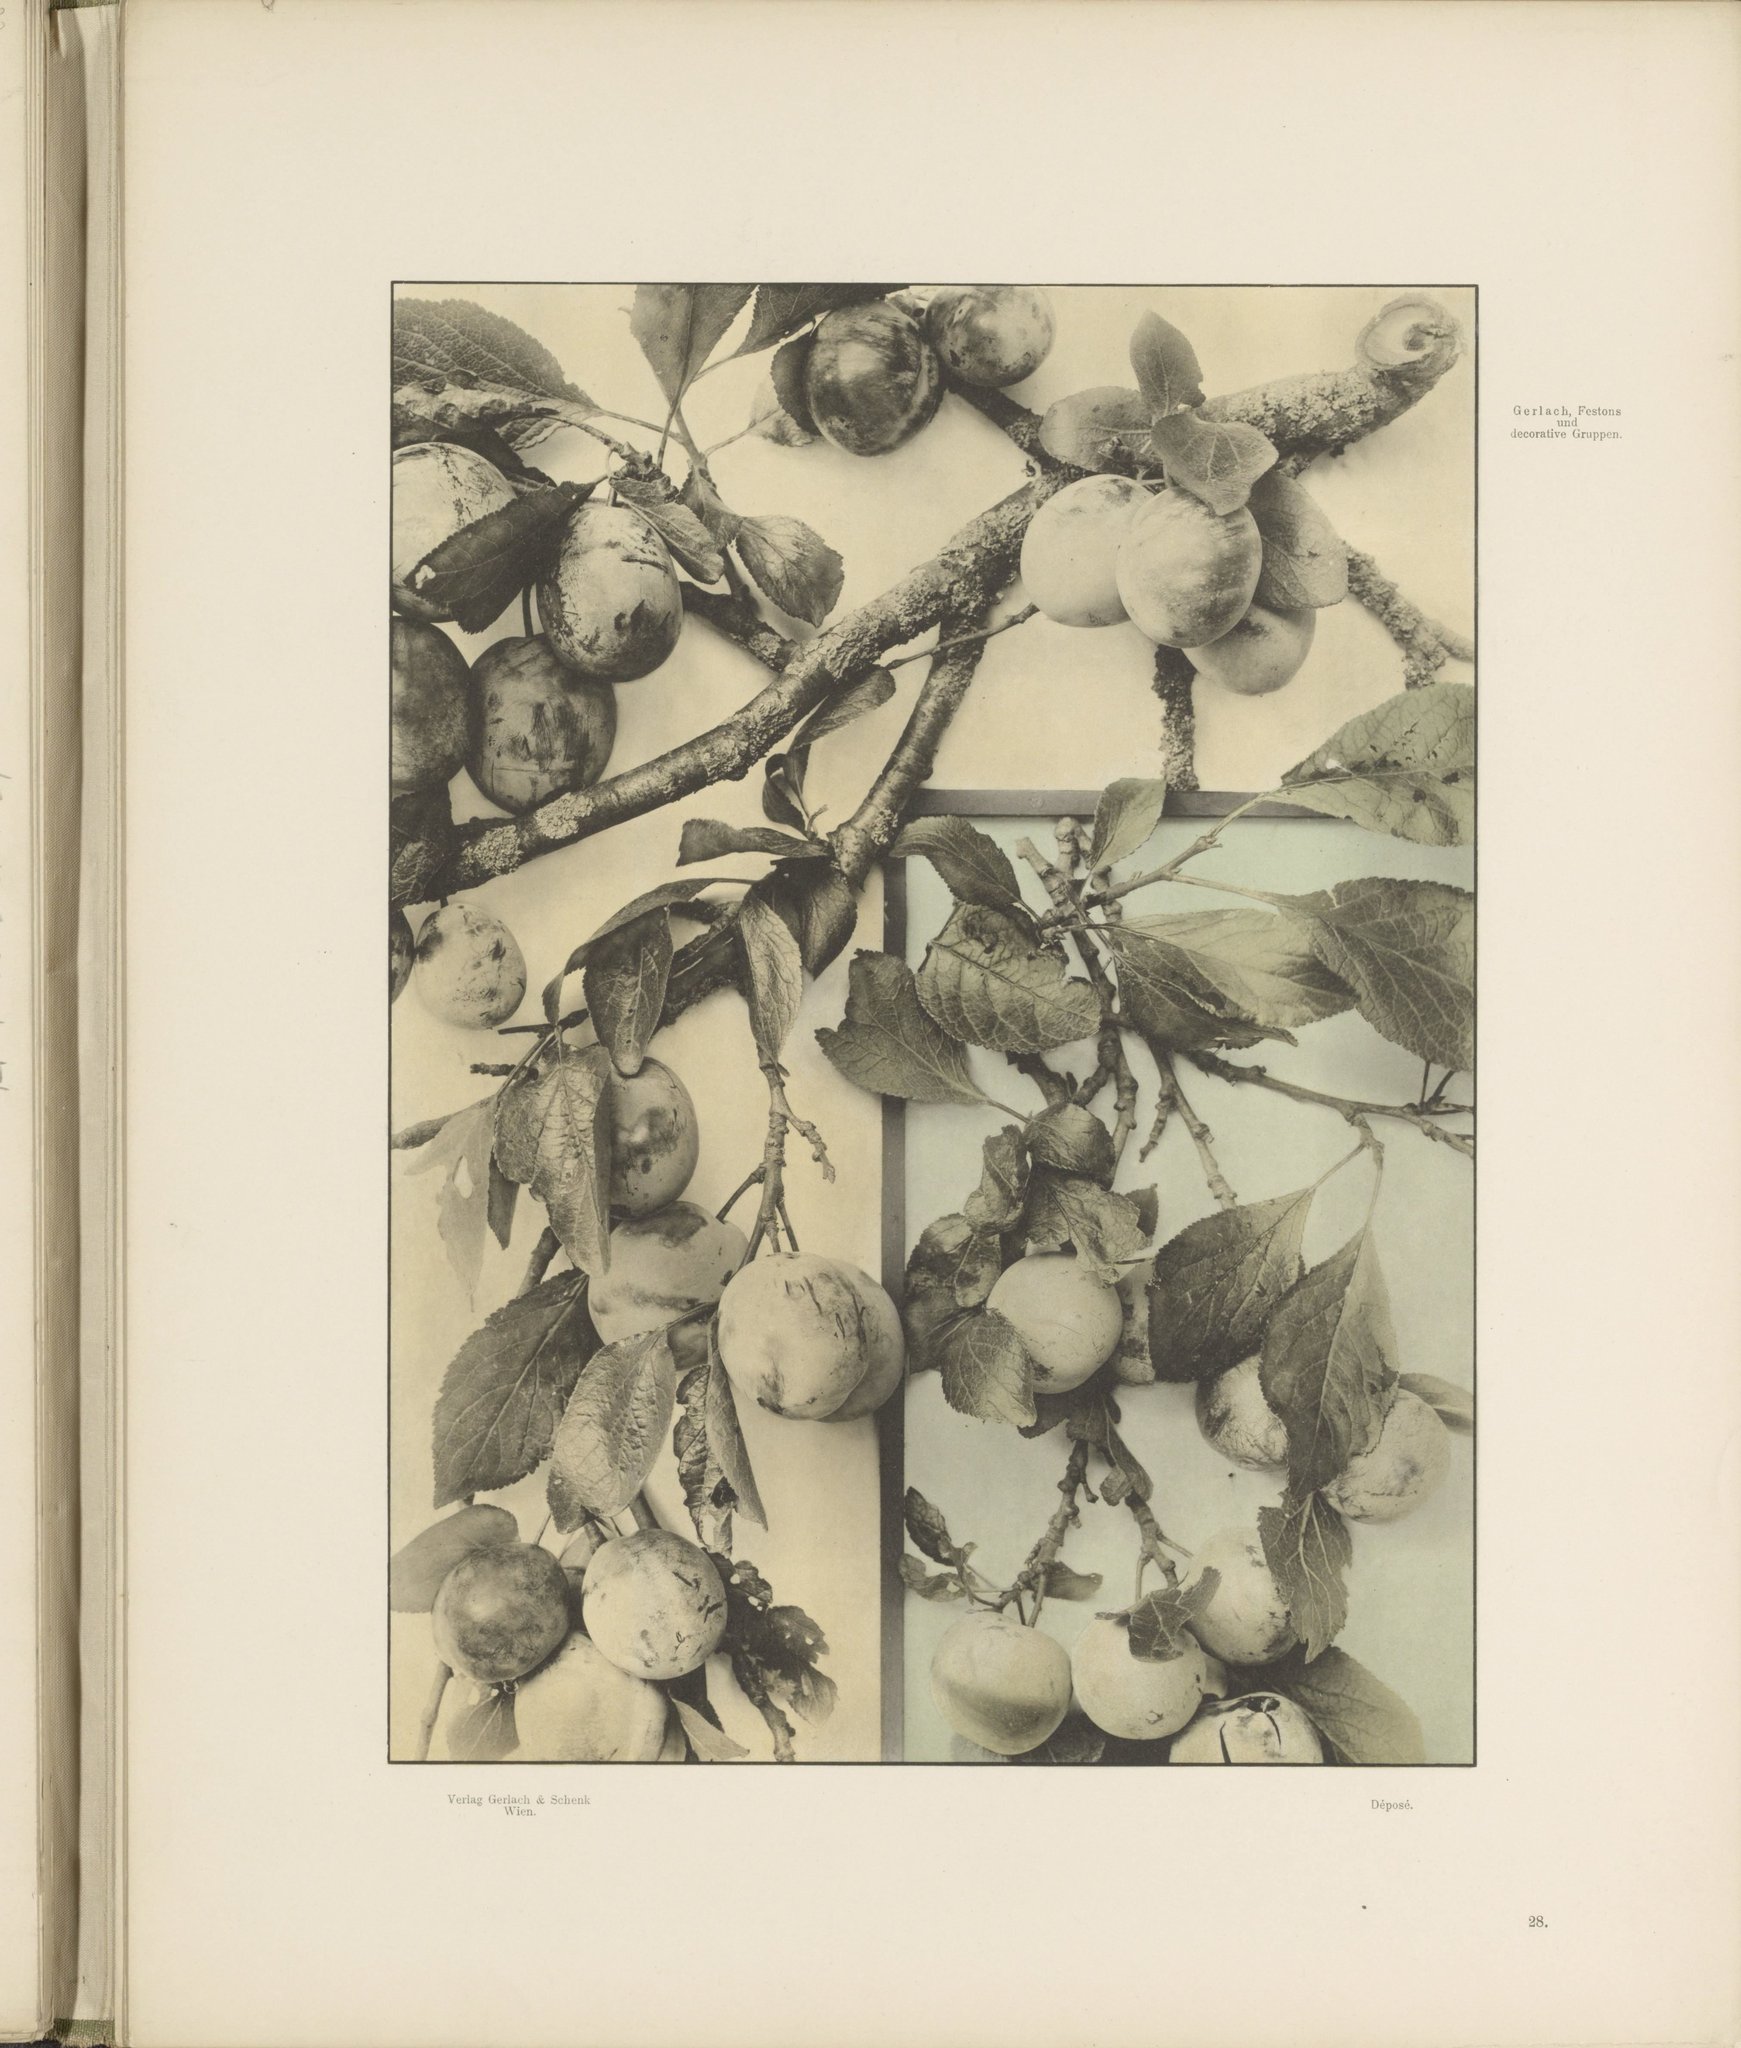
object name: page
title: Vlakken met kwetsen en reine-claudetakken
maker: Anonymous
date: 1887-1897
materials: paper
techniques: photograph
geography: austria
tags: tobacco, foliage, tendrils, branches ~ ornament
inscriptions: number: ‘28.’